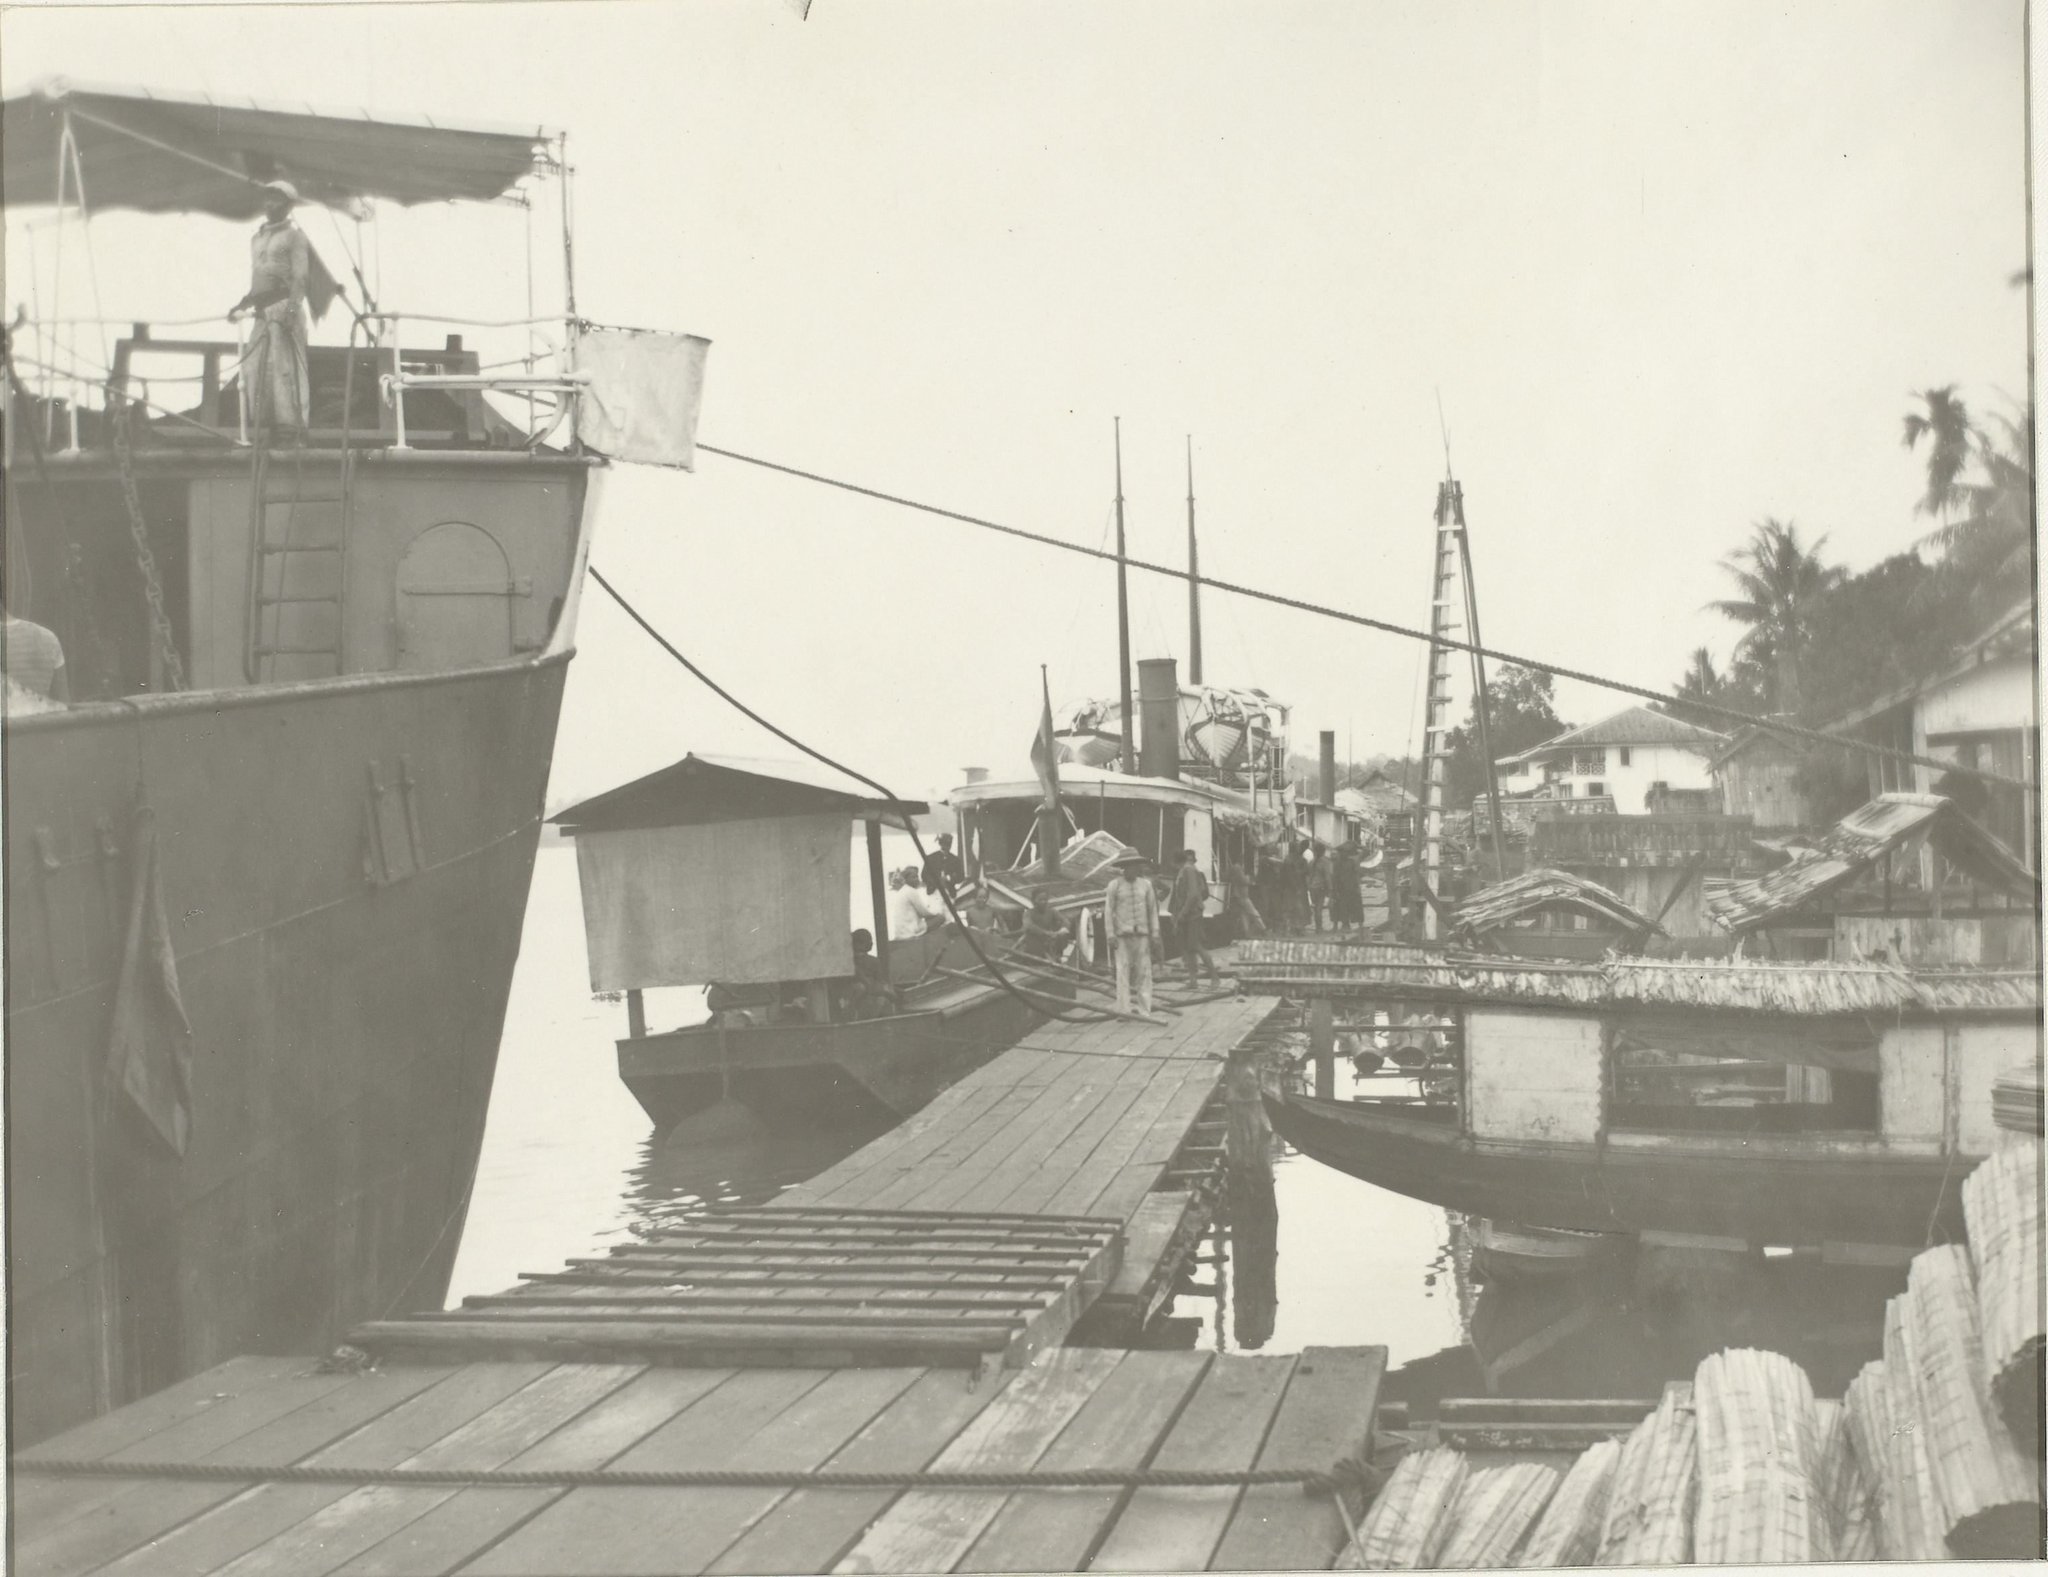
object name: album leaf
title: Schepen aan een steiger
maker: Anonymous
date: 1903-1907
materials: paper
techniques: gelatin silver print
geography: kalimantan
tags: pier, quay, wharf, traffic on the water, borneo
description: Schepen gelegen aan een steiger in een haven op Borneo. Foto in het fotoalbum over de oliewinning op Borneo door de Koninklijke Nederlandsche Petroleum Maatschappij (KNPM) in de jaren 1903-1907.